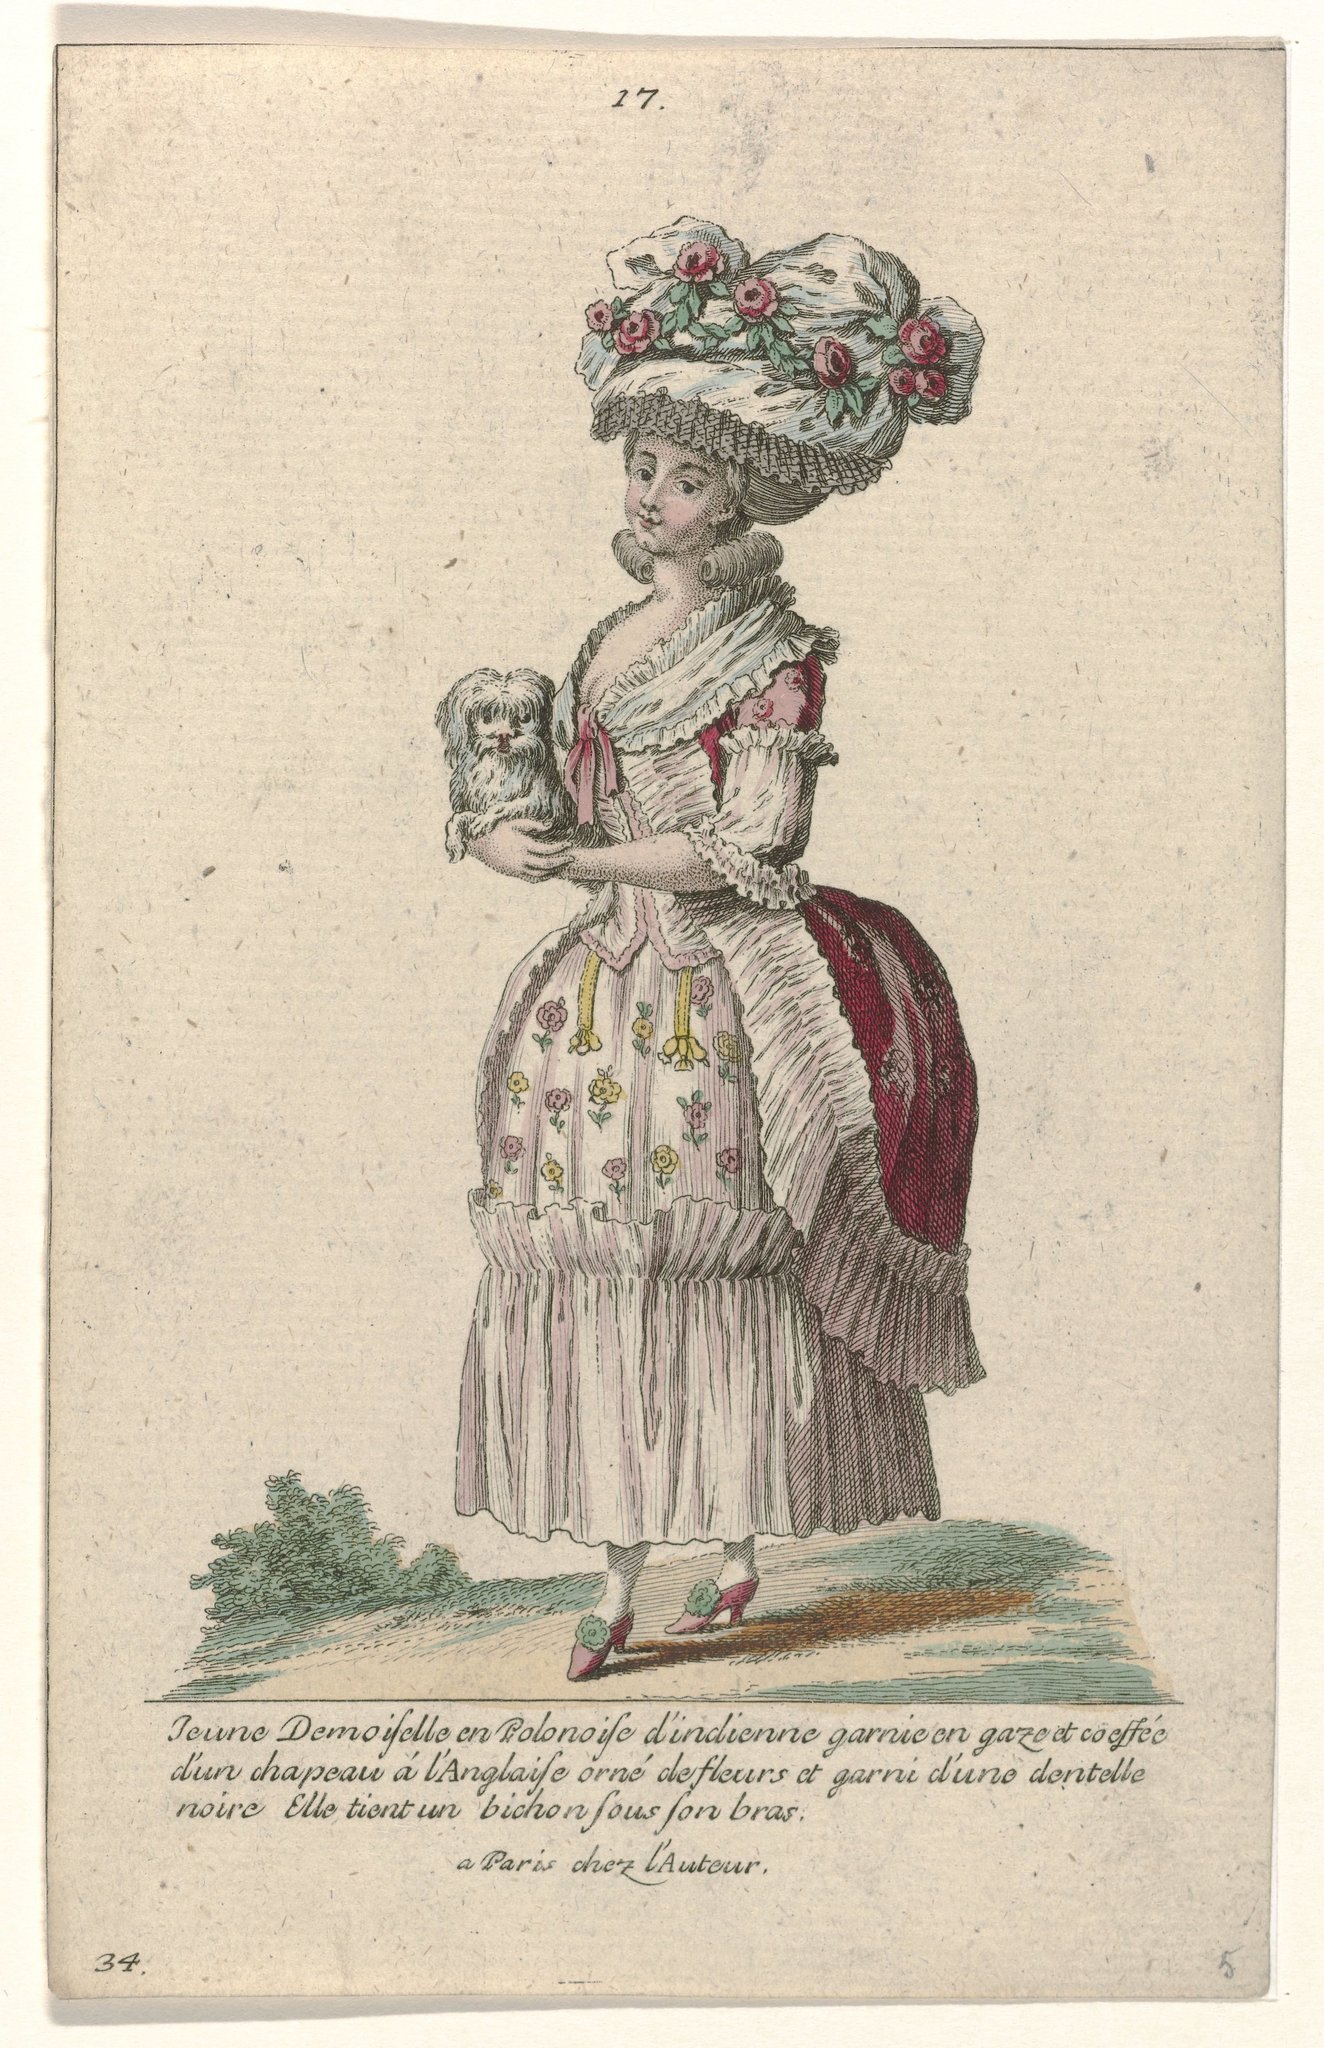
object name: fashion print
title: Gallerie des Modes et Costumes Français, 1785, nr. 17, nr. 34, Kopie naar Q 95 : Jeune Demoiselle en Polonoise d'indienn (...)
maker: pierre gleich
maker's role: print maker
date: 1785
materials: paper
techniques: engraving, hand coloring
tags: flowers, lace (+ women's clothes), fashion plates, head-gear: hat (+ women's clothes), skirt (+ women's clothes), sleeves (+ women's clothes), dog, dress, gown: robe à la polonaise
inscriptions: caption: ‘Jeune Demoiselle en Polonoise d'indienne garnie en gaze et coeffée d'un chapeau á Anglaise orné de fleurs et garni d'une dentelle noire Elle tient un bichon sous son bras.’, caption: ‘a Paris chez l'Auteur’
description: Jonge ongetrouwde vrouw, lopend naar links, met een maltezer hond onder de arm. Zij is gekleed in een robe à la Polonaise van 'indienne' (beschilderde of bedrukte katoen) versierd met tule. Op het hoofd een 'chapeau á Anglaise' versierd met bloemen en gegarneerd met zwart kant. Verdere accessoires: chatelaines, schoenen met hakken en rozetten (?). Kopie naar Q 95 uit serie Q. 16e Cahier des Costumes Français, 10e Suite d'Habillemens à la mode, Gallerie des Modes et Costumes Français.